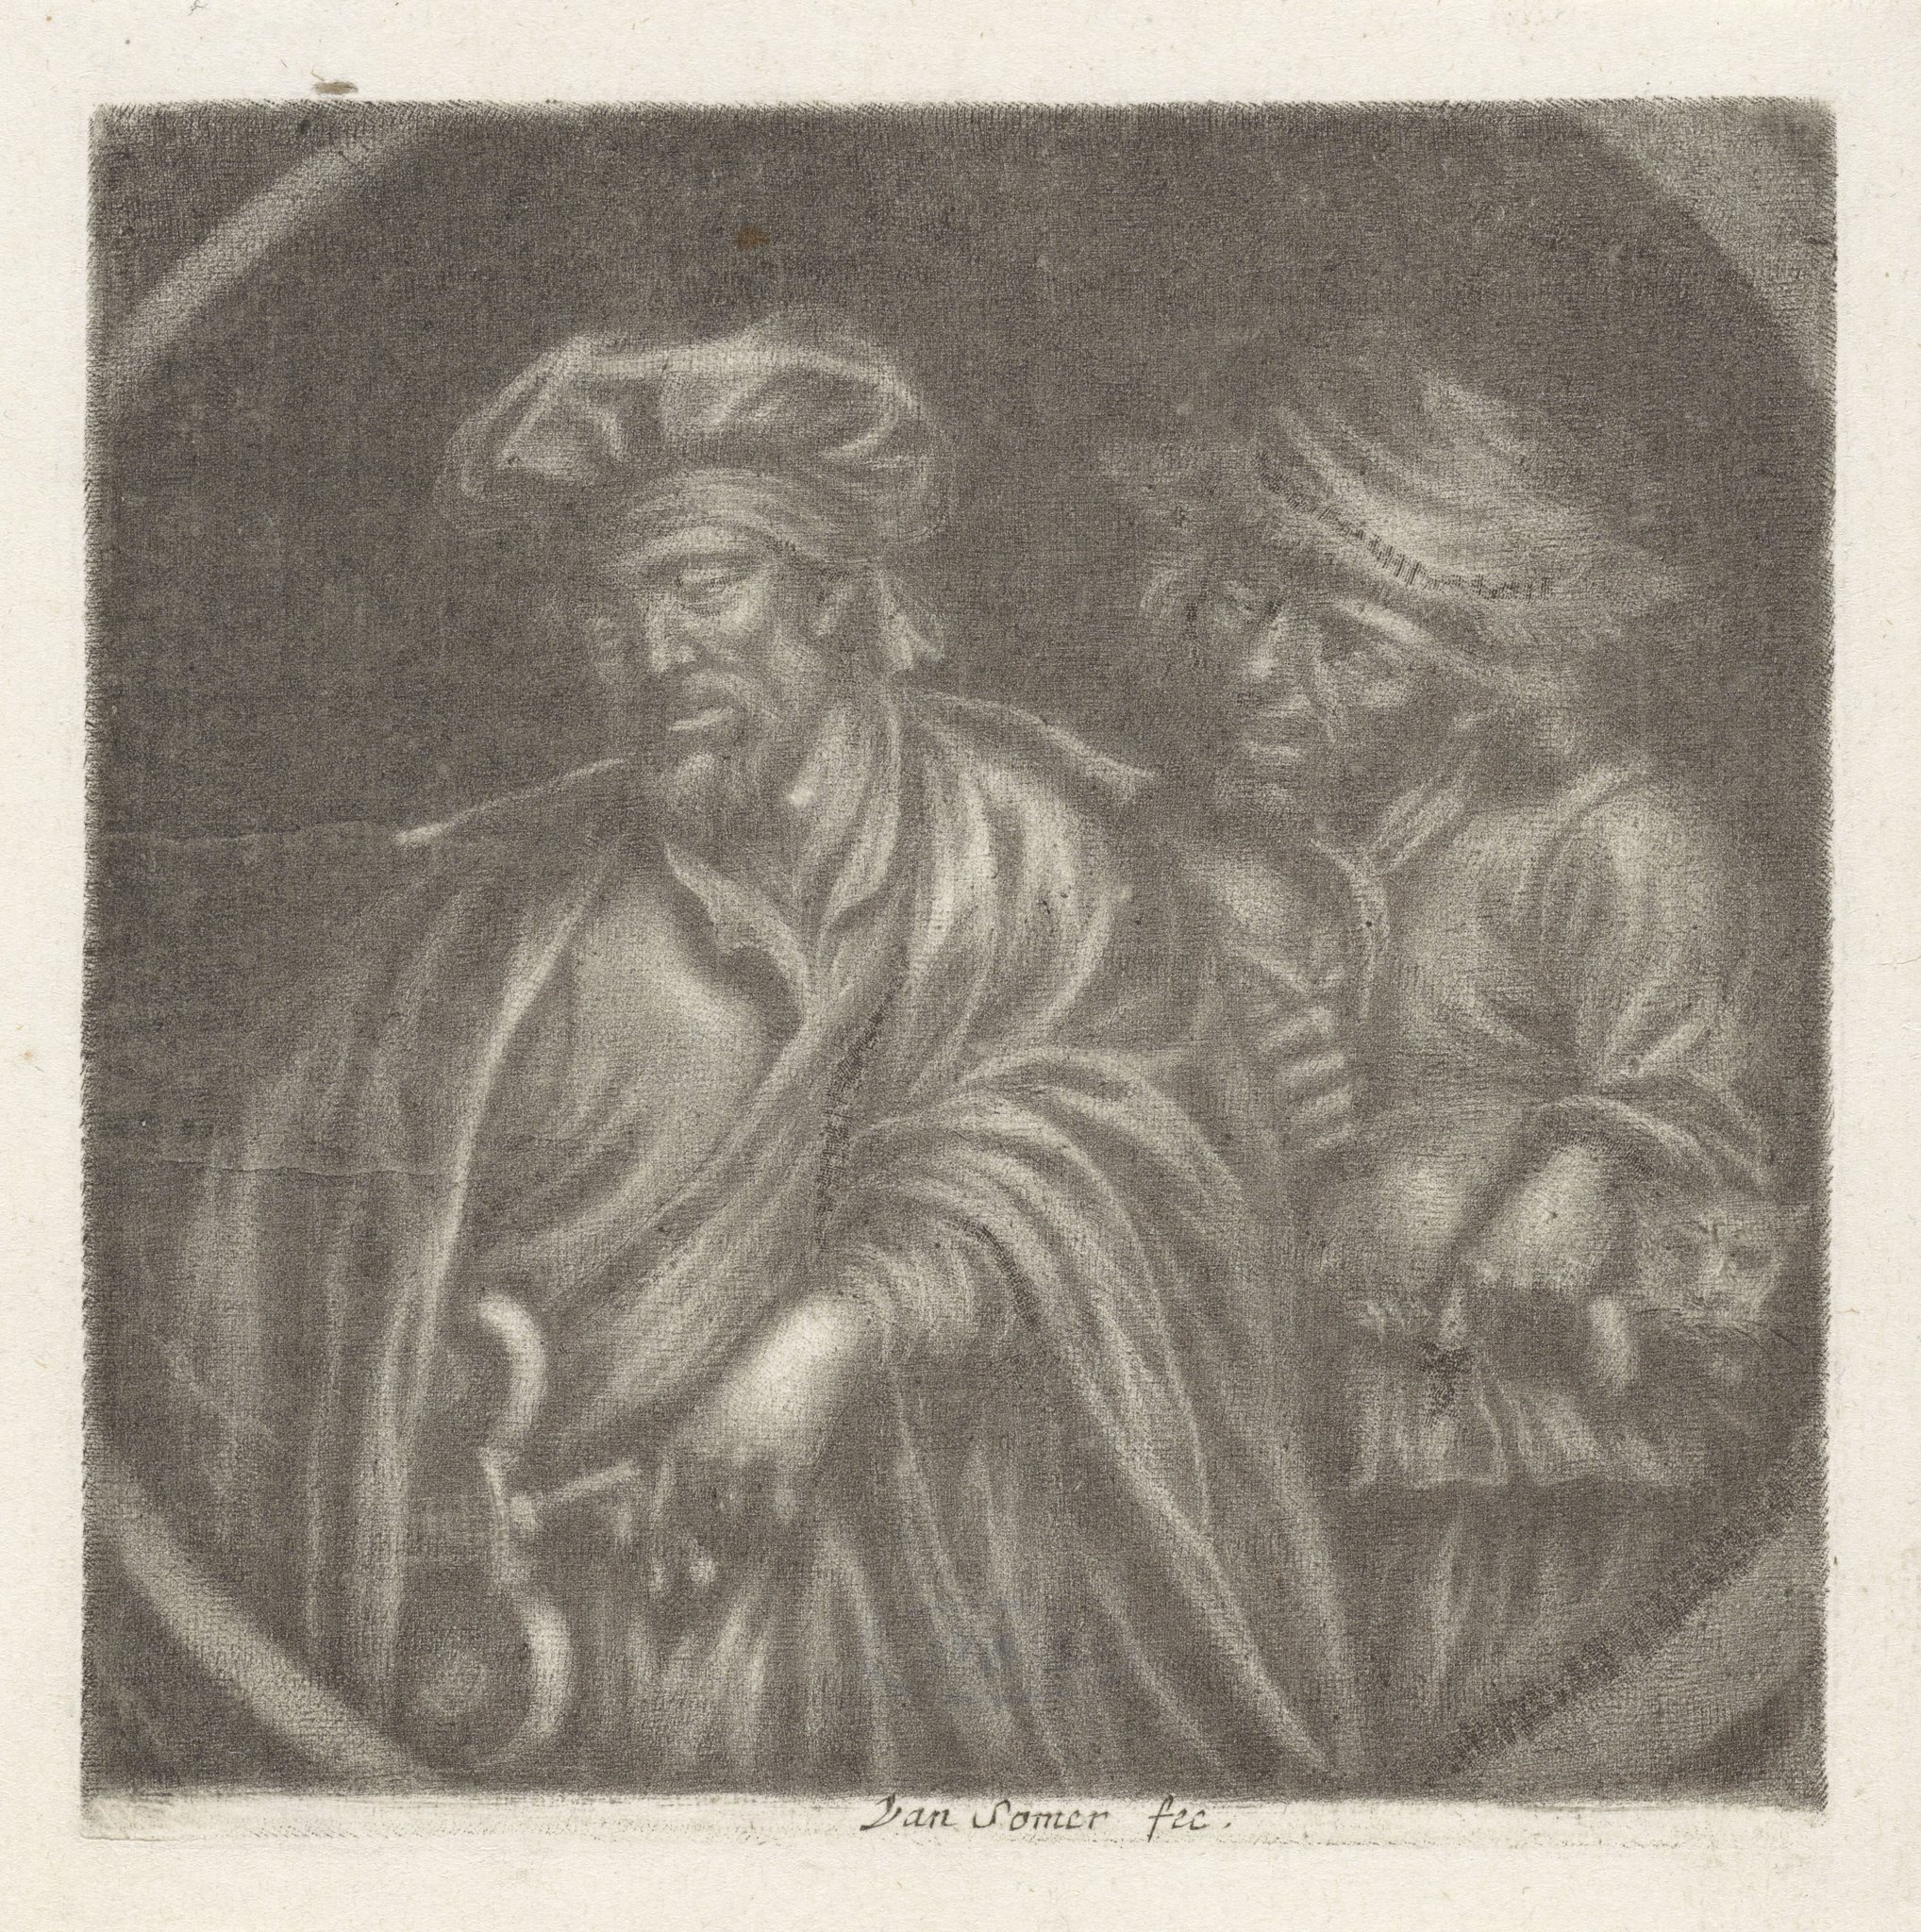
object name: print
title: Muzikanten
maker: jan van somer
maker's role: draughtsman, print maker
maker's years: 1645-1699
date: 1655-1700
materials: paper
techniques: mezzotint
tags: cat, hurdy-gurdy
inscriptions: collector's mark: Lugt 2228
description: Een lierspeler draait aan zijn draailier terwijl een man, met een kat onder de arm, luistert.